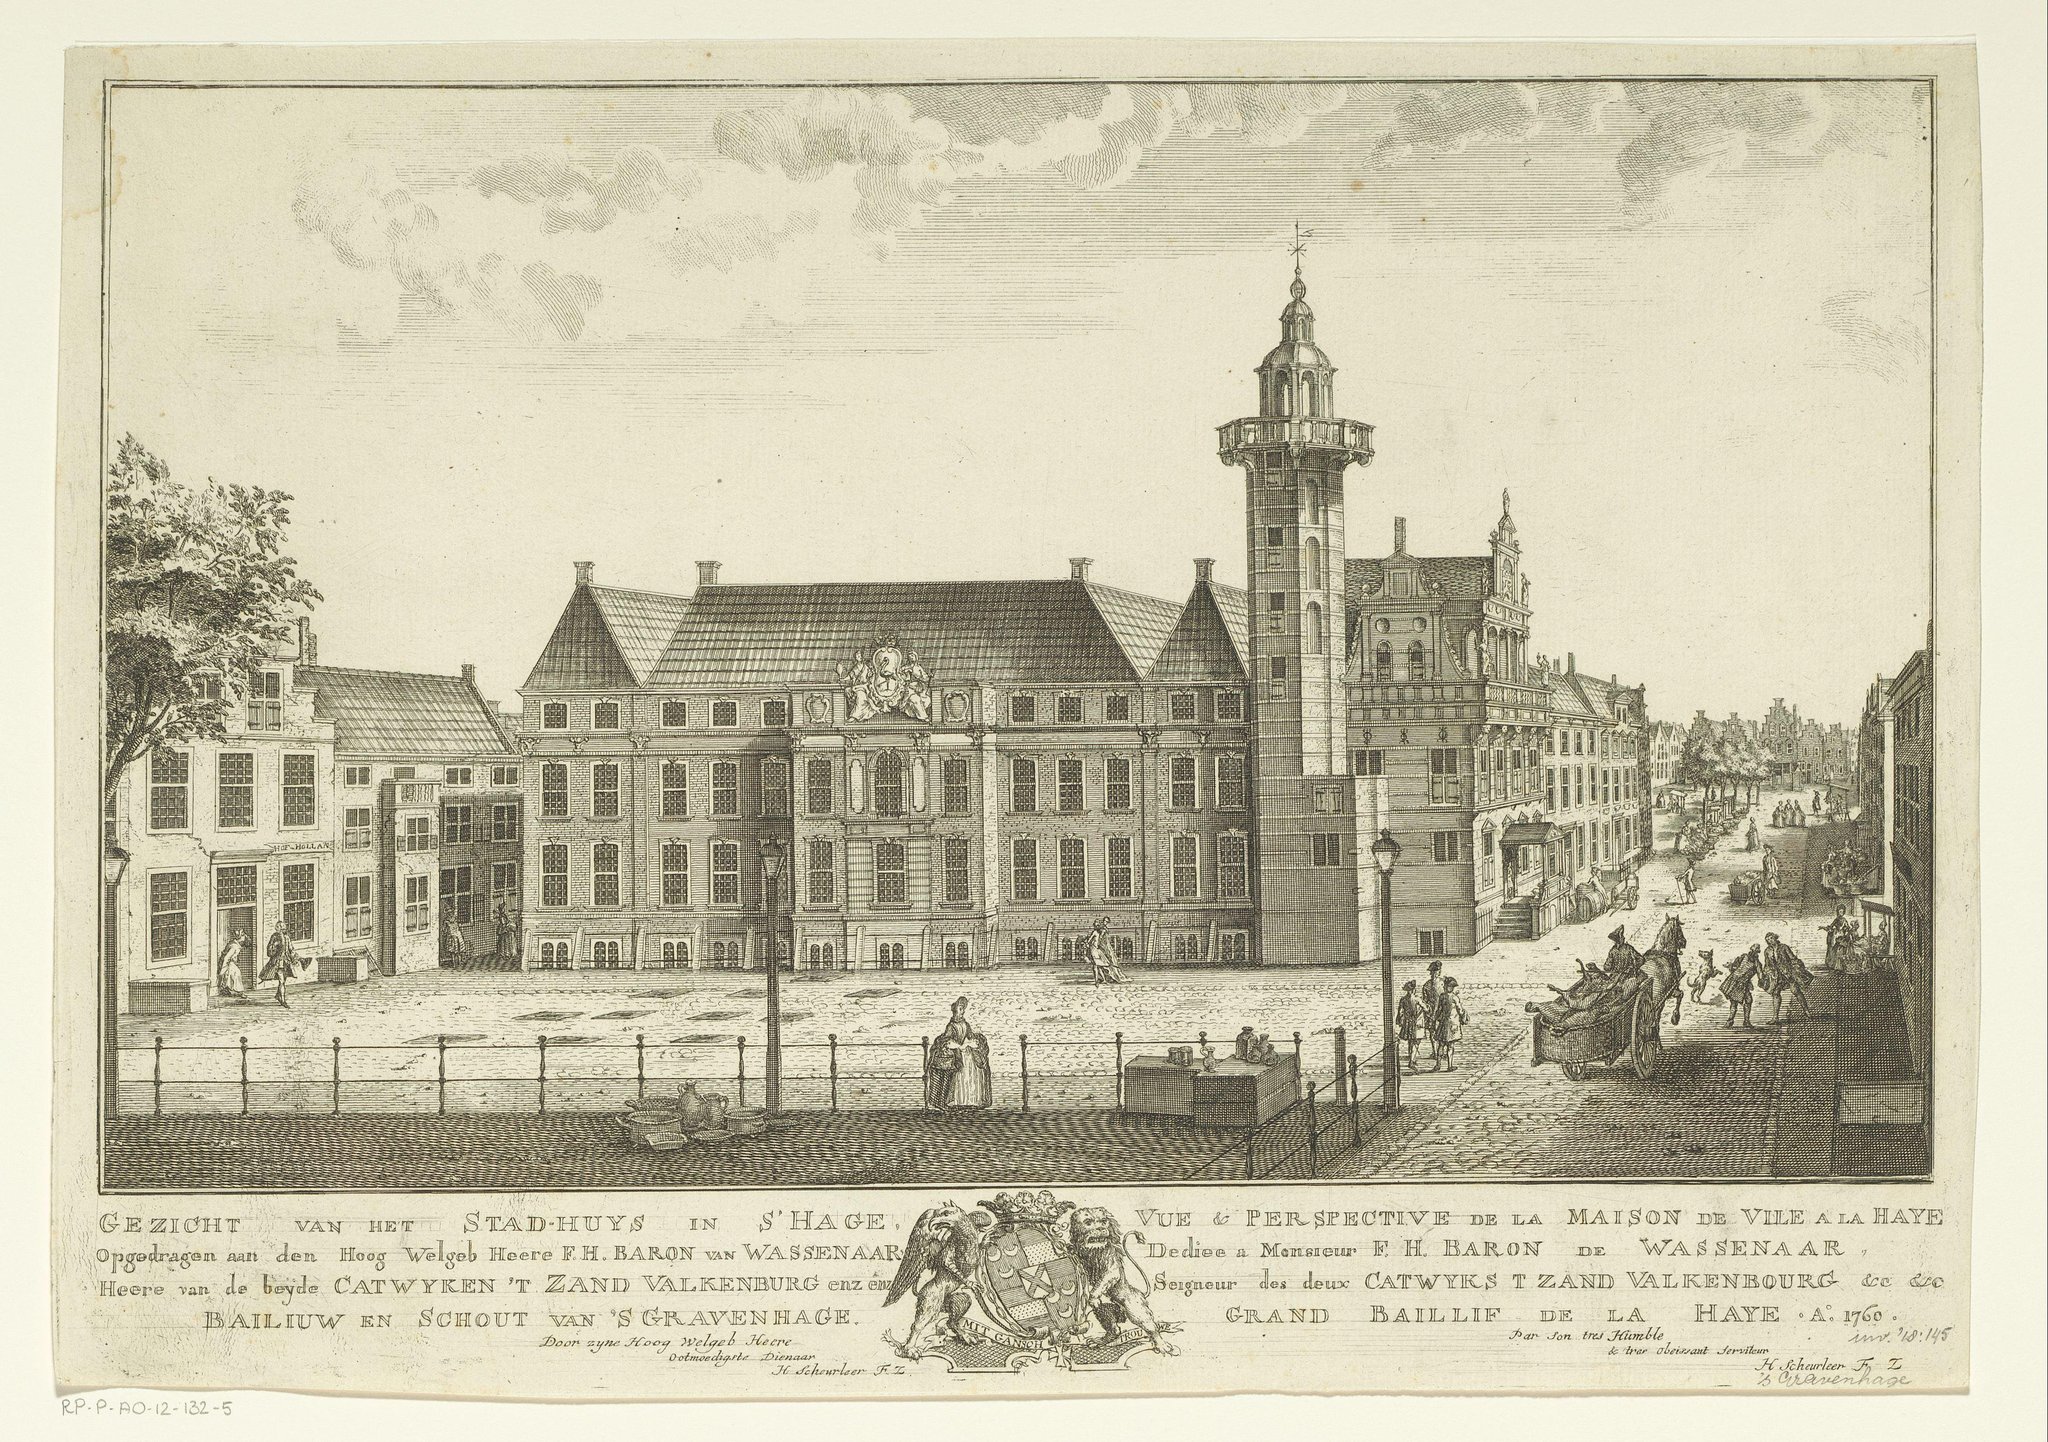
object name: print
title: Achttien gezichten in en om Den Haag (Besoet / Scheurleer)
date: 1760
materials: paper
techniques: engraving, etching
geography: the hague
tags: townhall, armorial bearing, heraldry, street (+ city(-scape) with figures, staffage)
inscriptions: collector's mark: Lugt 2228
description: Gezicht op het Oude Stadhuis aan de Dagelijkse Groenmarkt te Den Haag, gezien vanaf de Riviervismarkt. Onder de voorstelling de titel en opdracht in het Nederlands en Frans, met in het midden het familiewapen van de Haagse baljuw en schout Frederik Hendrik baron van Wassenaer. Prent uit een serie van achttien gezichten in en om Den Haag.